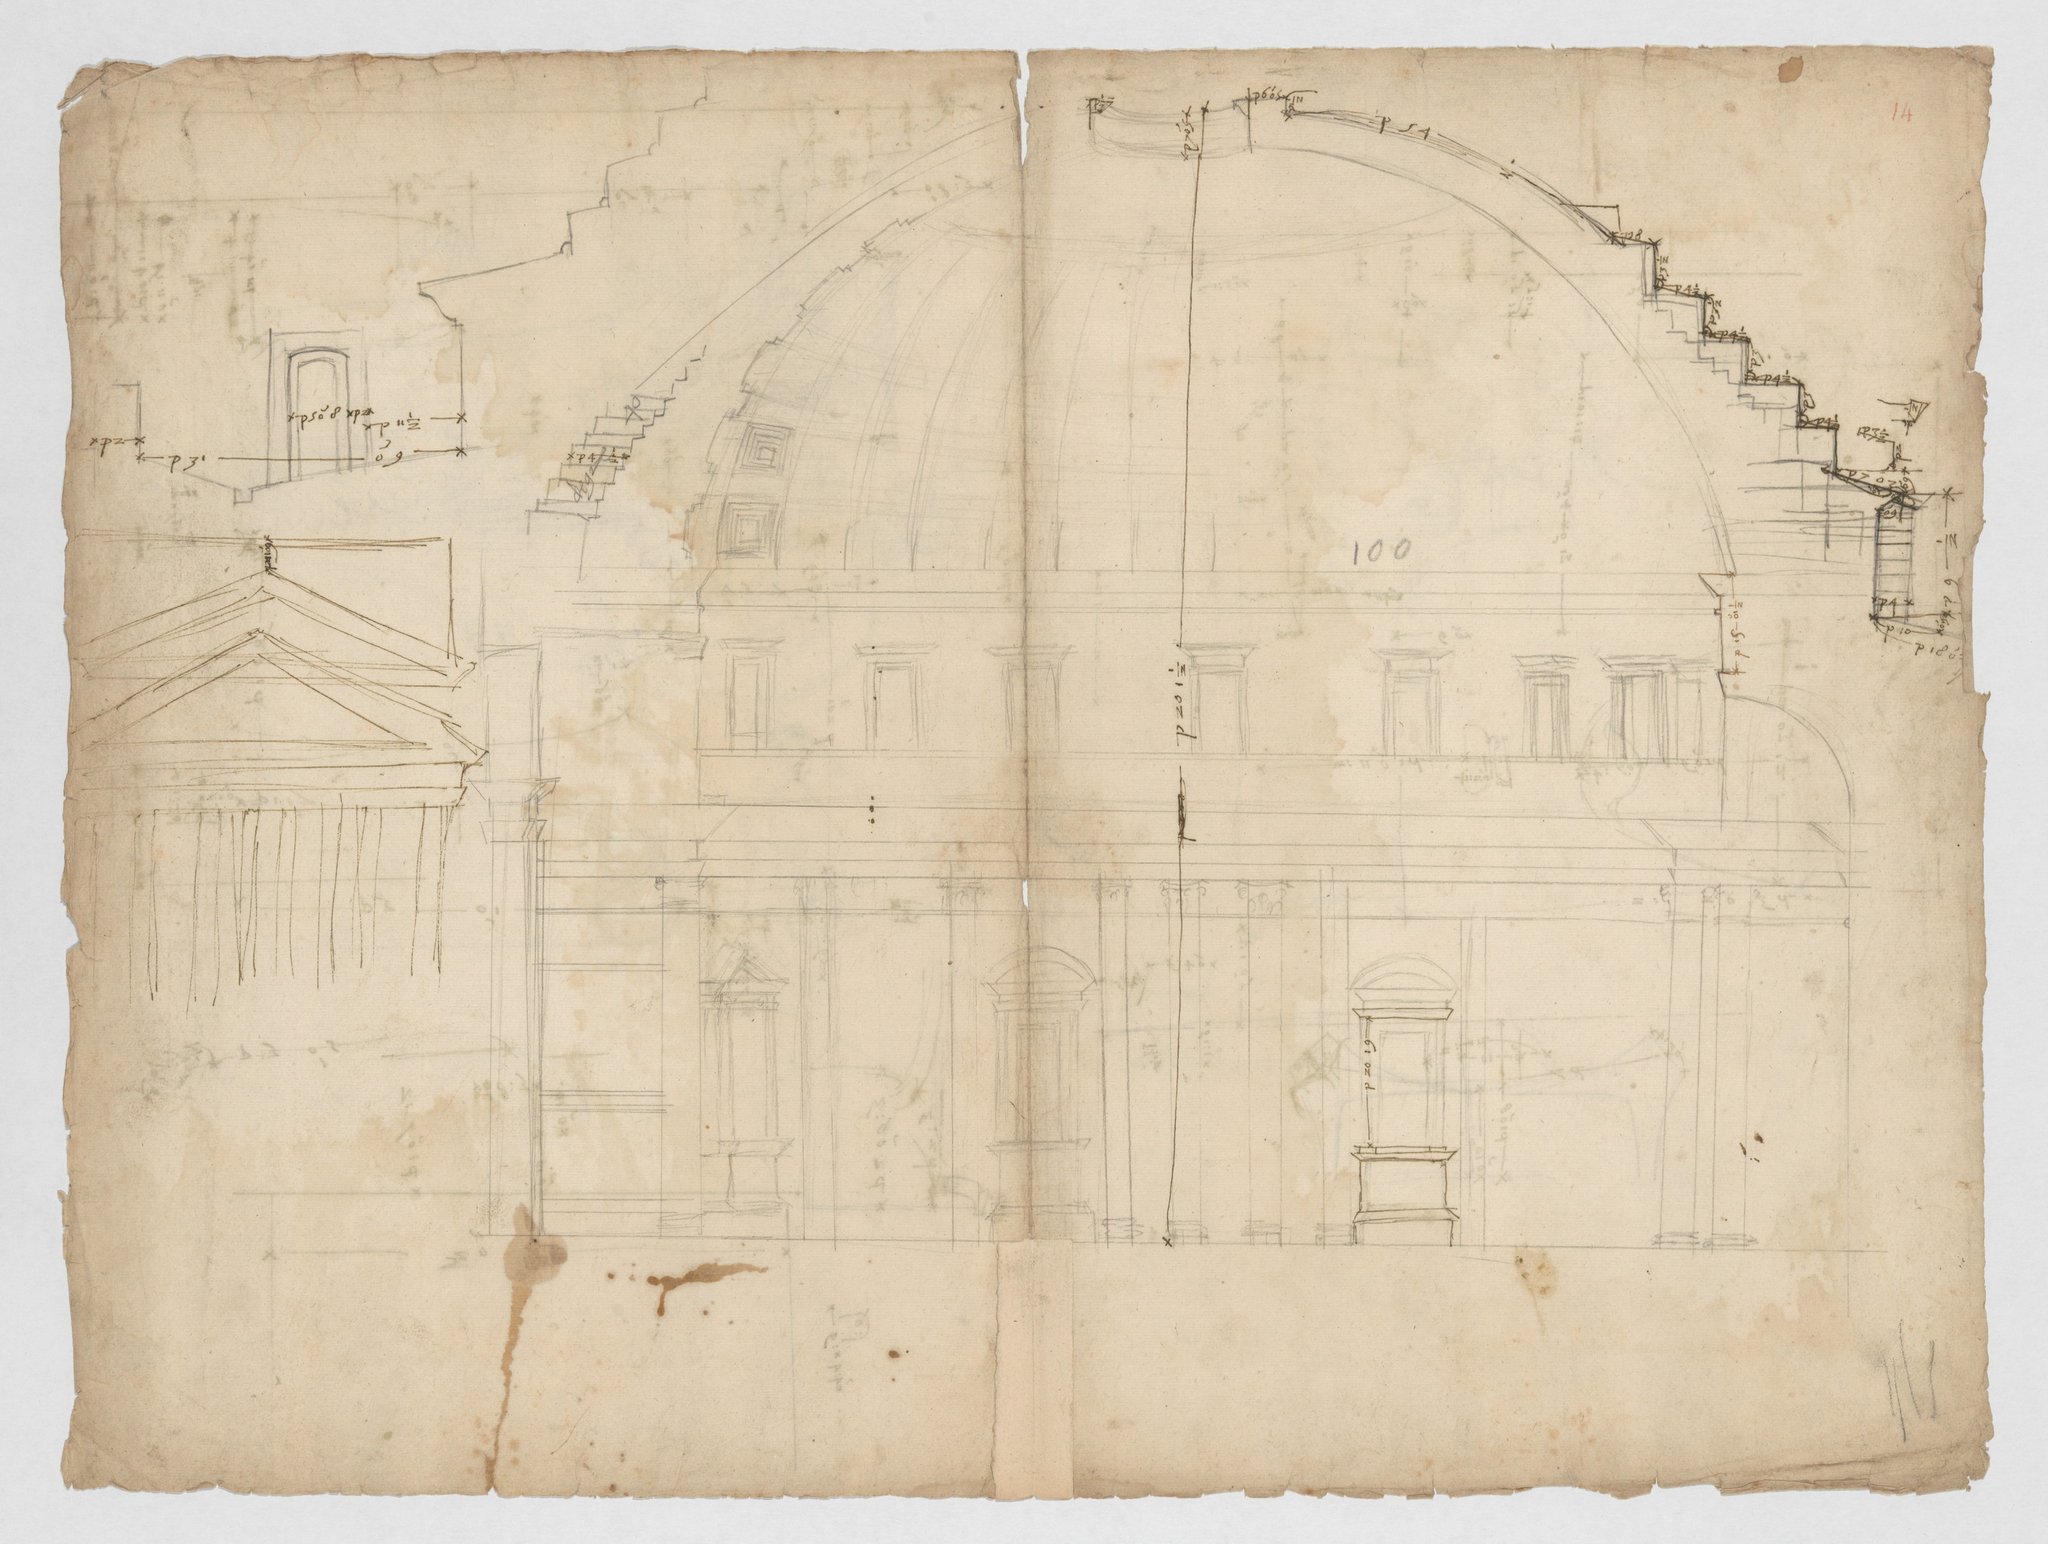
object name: collection ornament architecture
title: Pantheon, section (recto) Pantheon, capital, elevation; capital, details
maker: anonymous, french, 16th century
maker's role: draftsman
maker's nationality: french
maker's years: 1500-1600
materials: chalk, ink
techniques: incising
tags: architecture